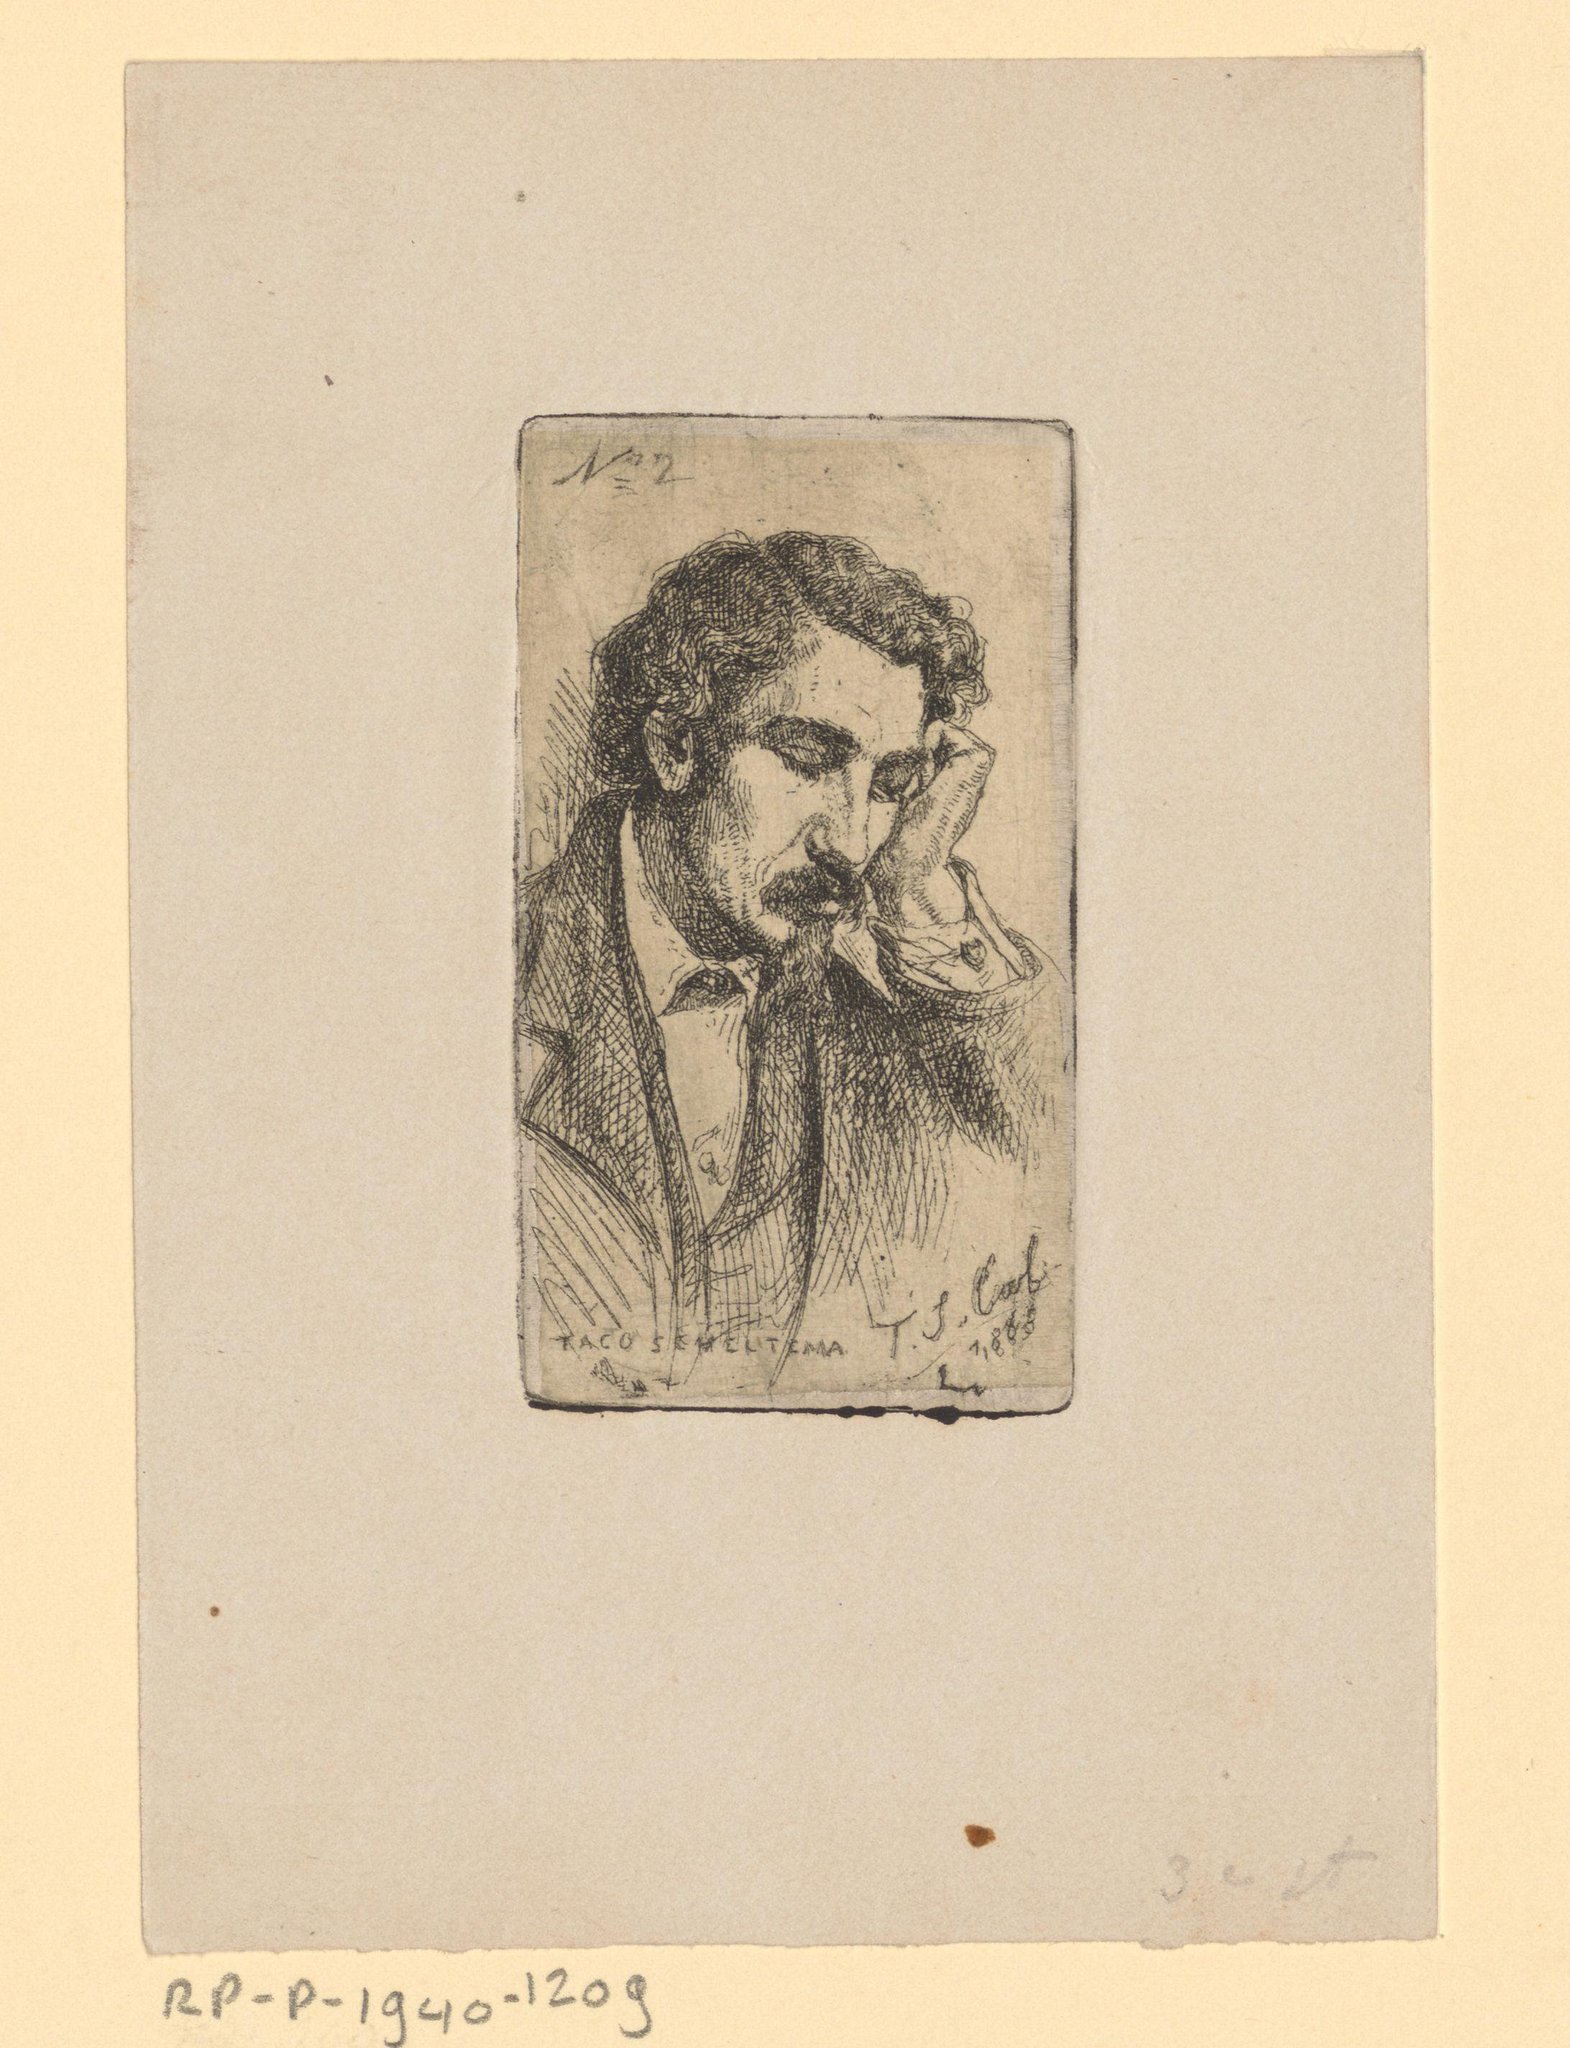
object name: print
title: Portret van Taco Jan Scheltema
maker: thomas simon cool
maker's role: draughtsman, print maker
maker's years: 1831-1870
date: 1863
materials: paper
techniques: etching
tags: arnhem, the hague, draughtsman, taco jan scheltema, historical persons, portrait, self-portrait of artist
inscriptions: collector's mark: Lugt 2760, collector's mark: Lugt 2228